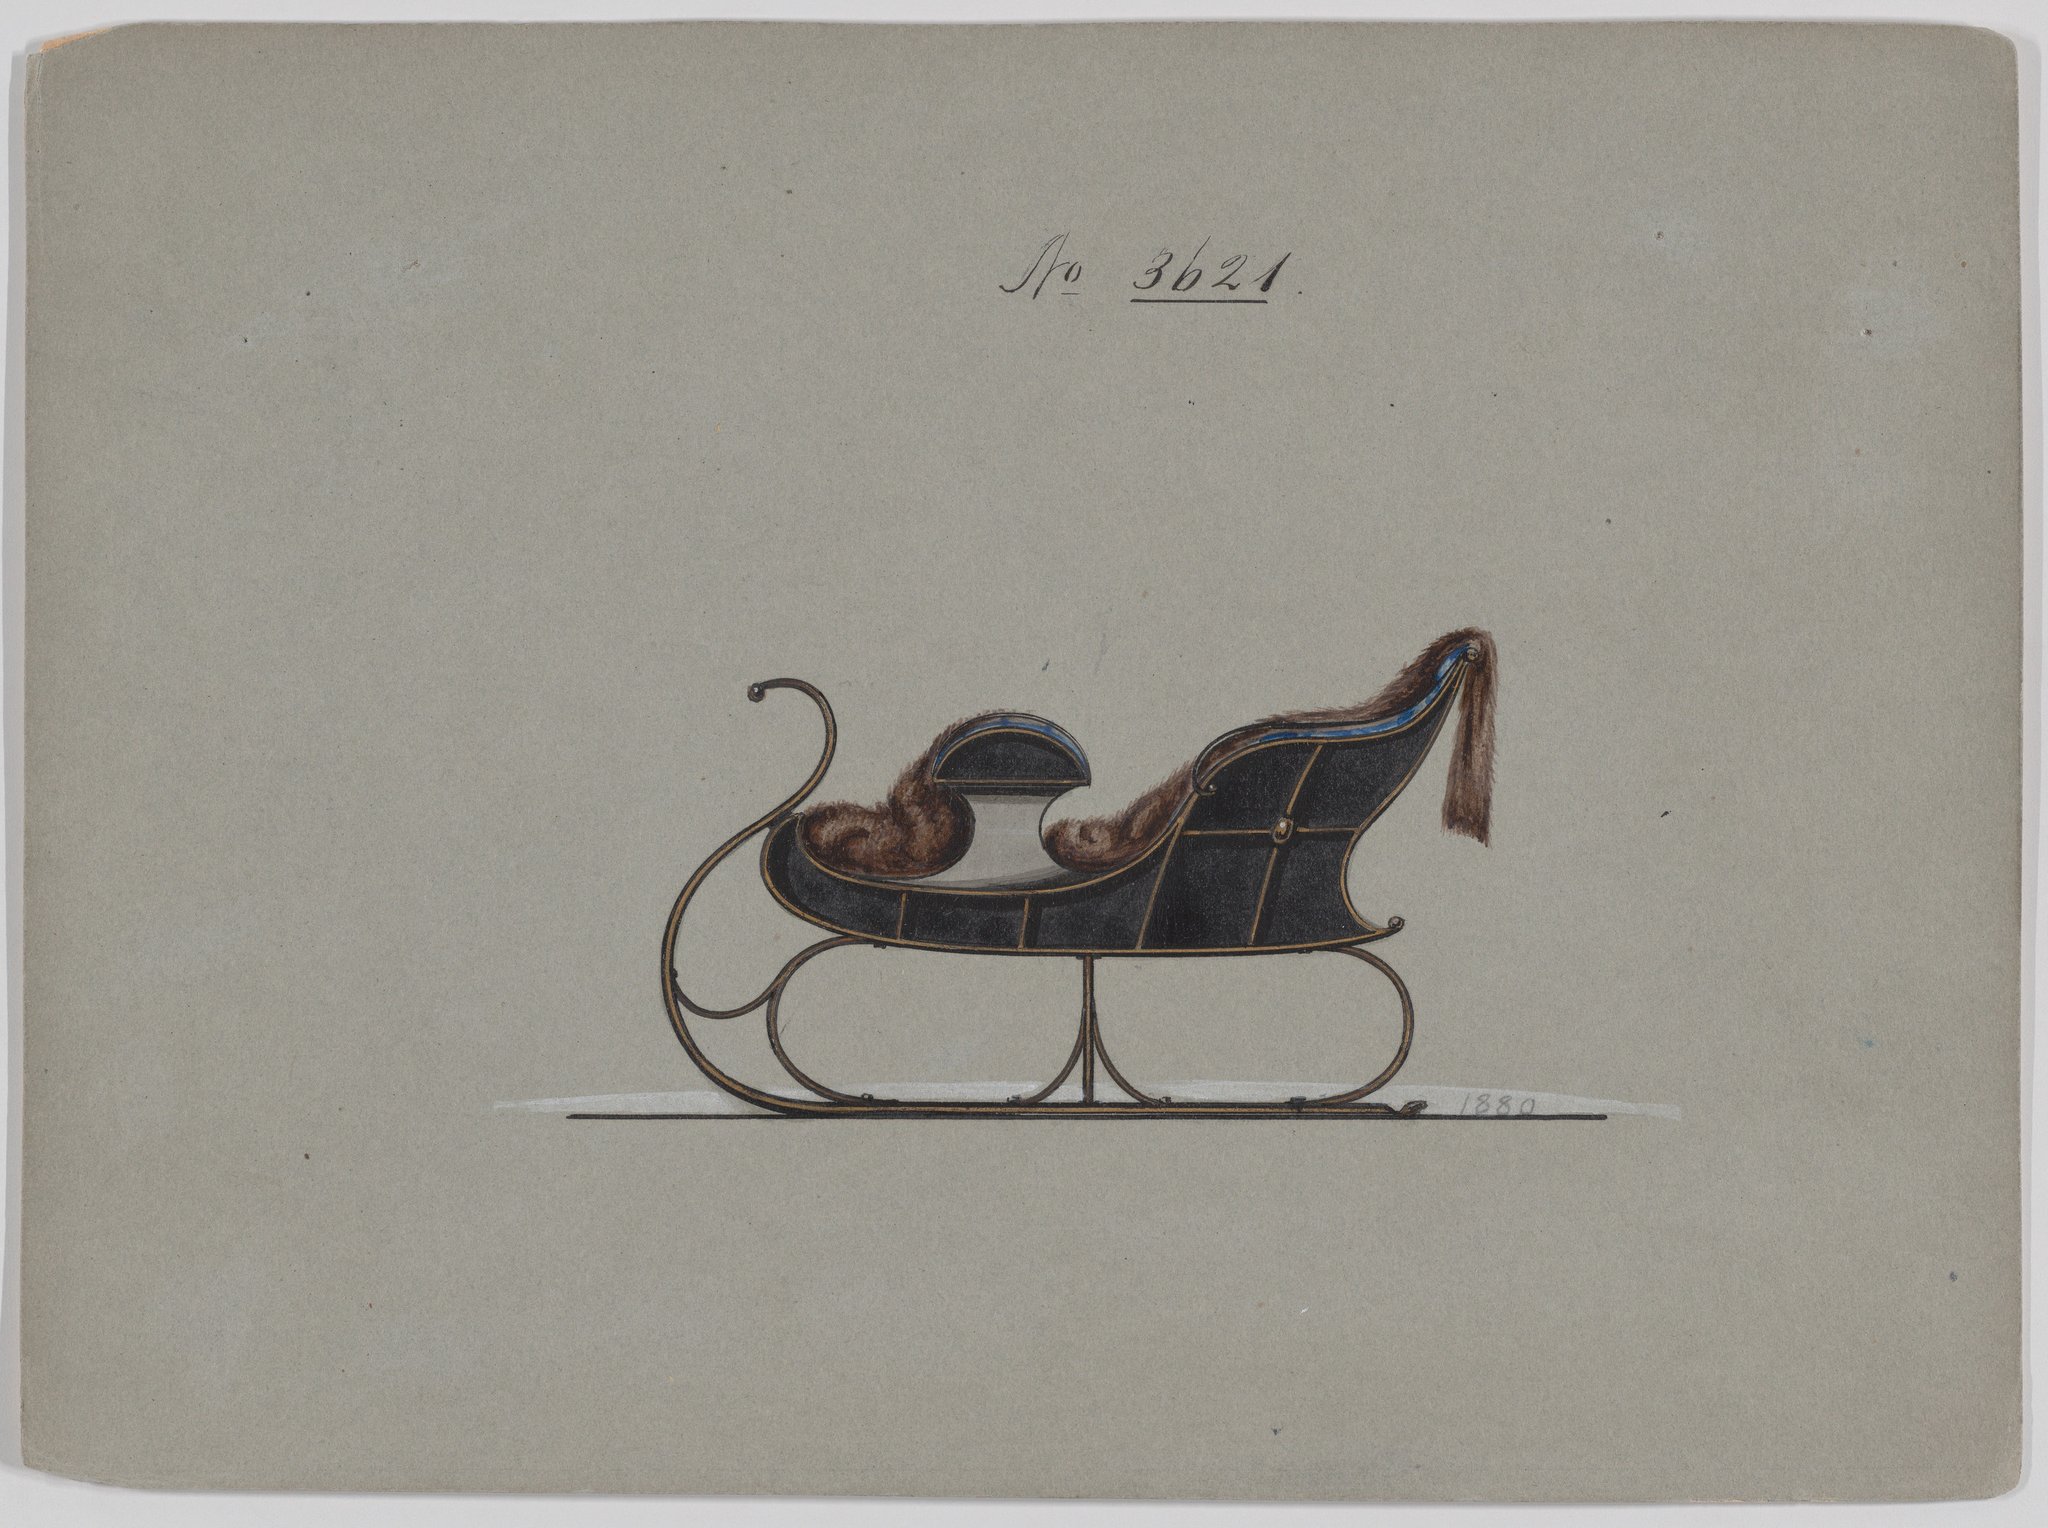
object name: drawing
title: Design for 4 Seat Sleigh, no. 3621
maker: brewster & co.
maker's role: manufacturer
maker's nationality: american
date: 1880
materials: gouache, gum arabic, ink, watercolor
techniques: pen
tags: sleighs